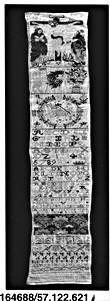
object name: sampler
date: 1756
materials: linen, silk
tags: human figures